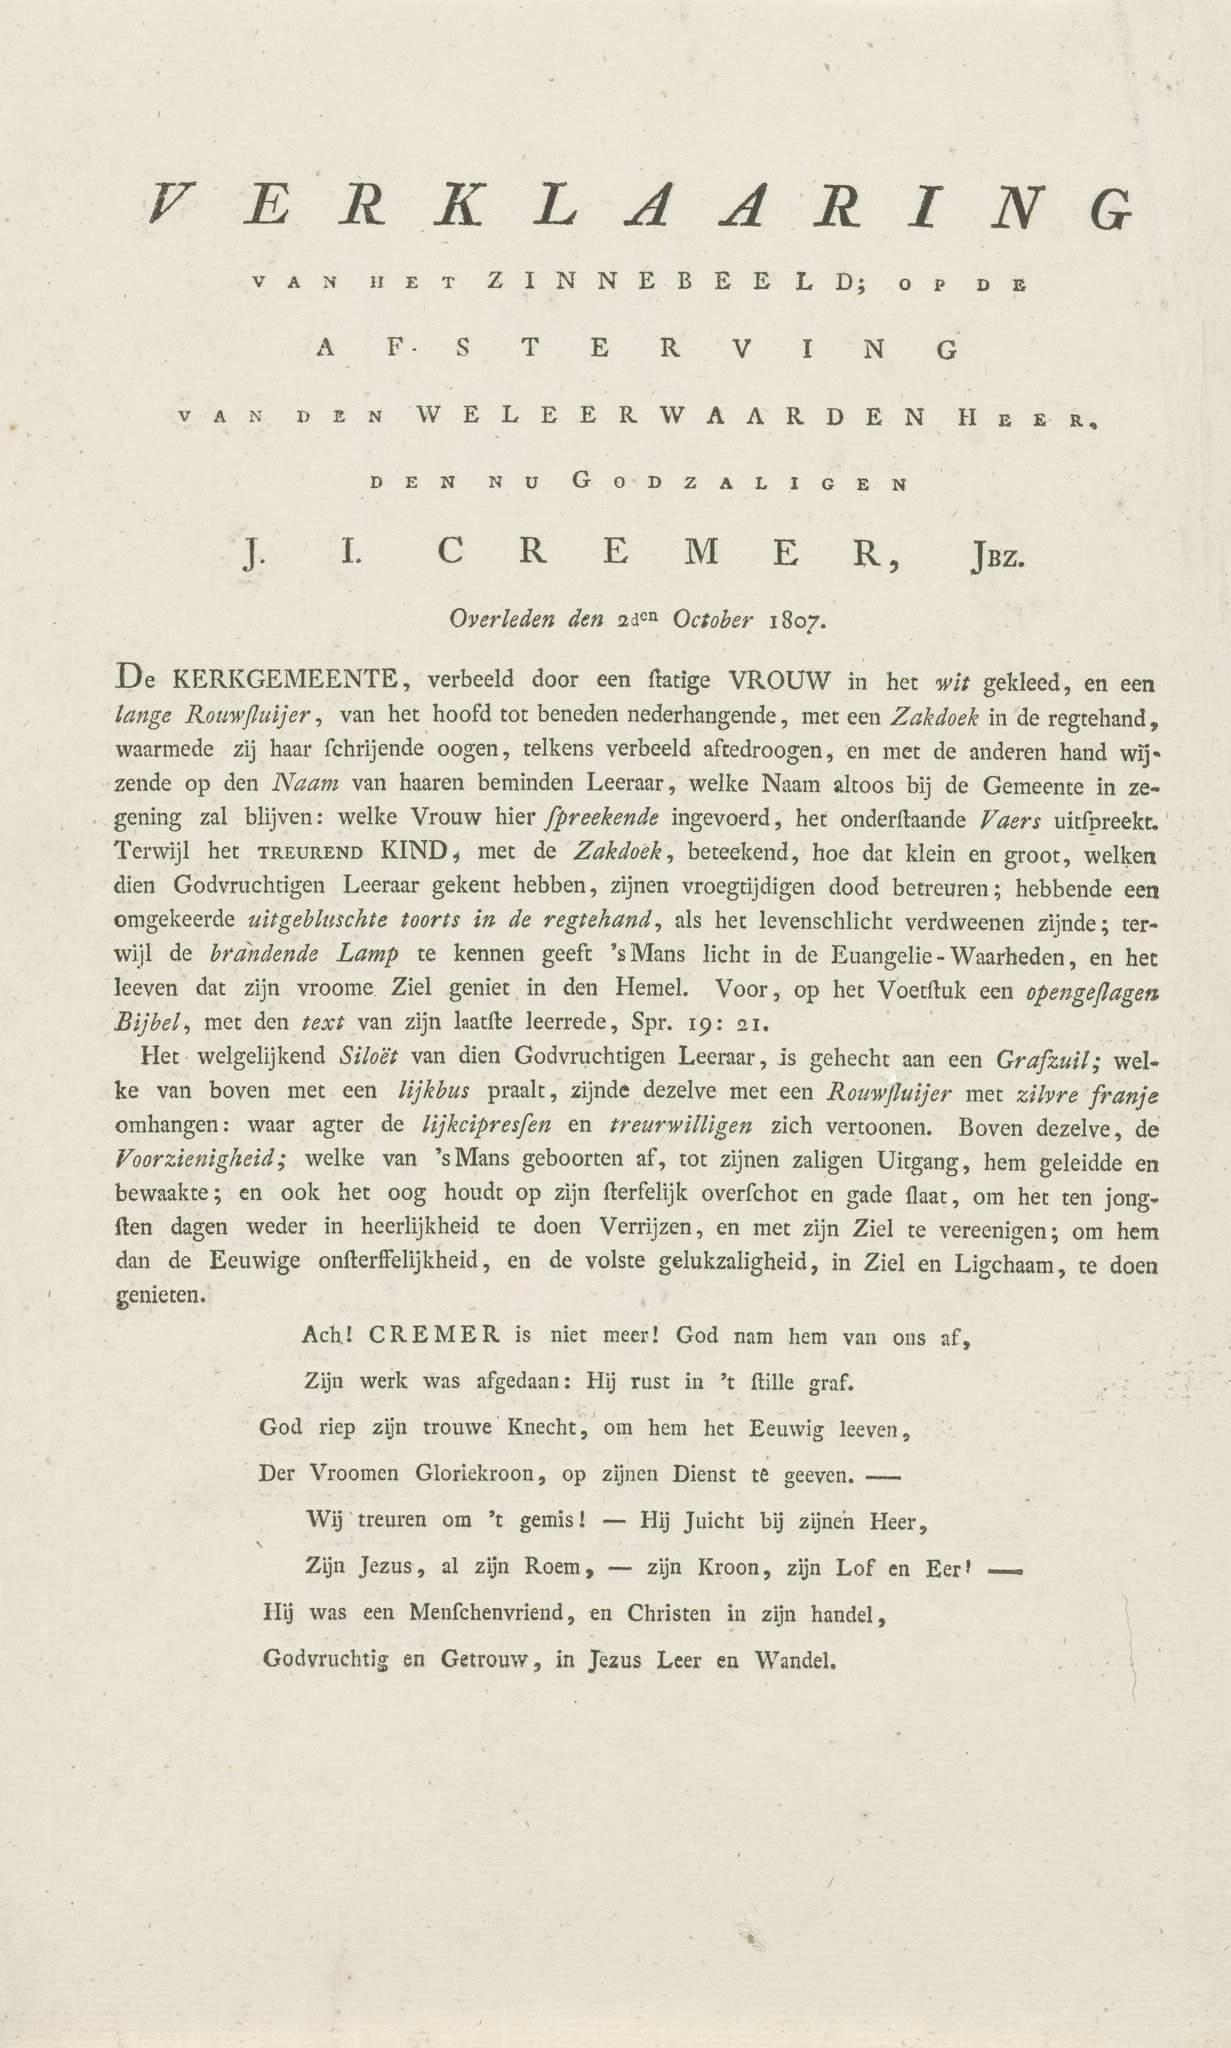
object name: text sheet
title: Verklaring van het gedenkteken voor Joost Izaak Cremer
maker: noach van der meer (ii)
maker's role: draughtsman, print maker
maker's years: 1741-1822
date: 1807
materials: paper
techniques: letterpress printing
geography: amsterdam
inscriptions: collector's mark: Lugt 2228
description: Verklarende tekst bij het in prent uitgebrachtte gedenkteken voor Joost Izaak Cremer, predikant te Amsterdam.